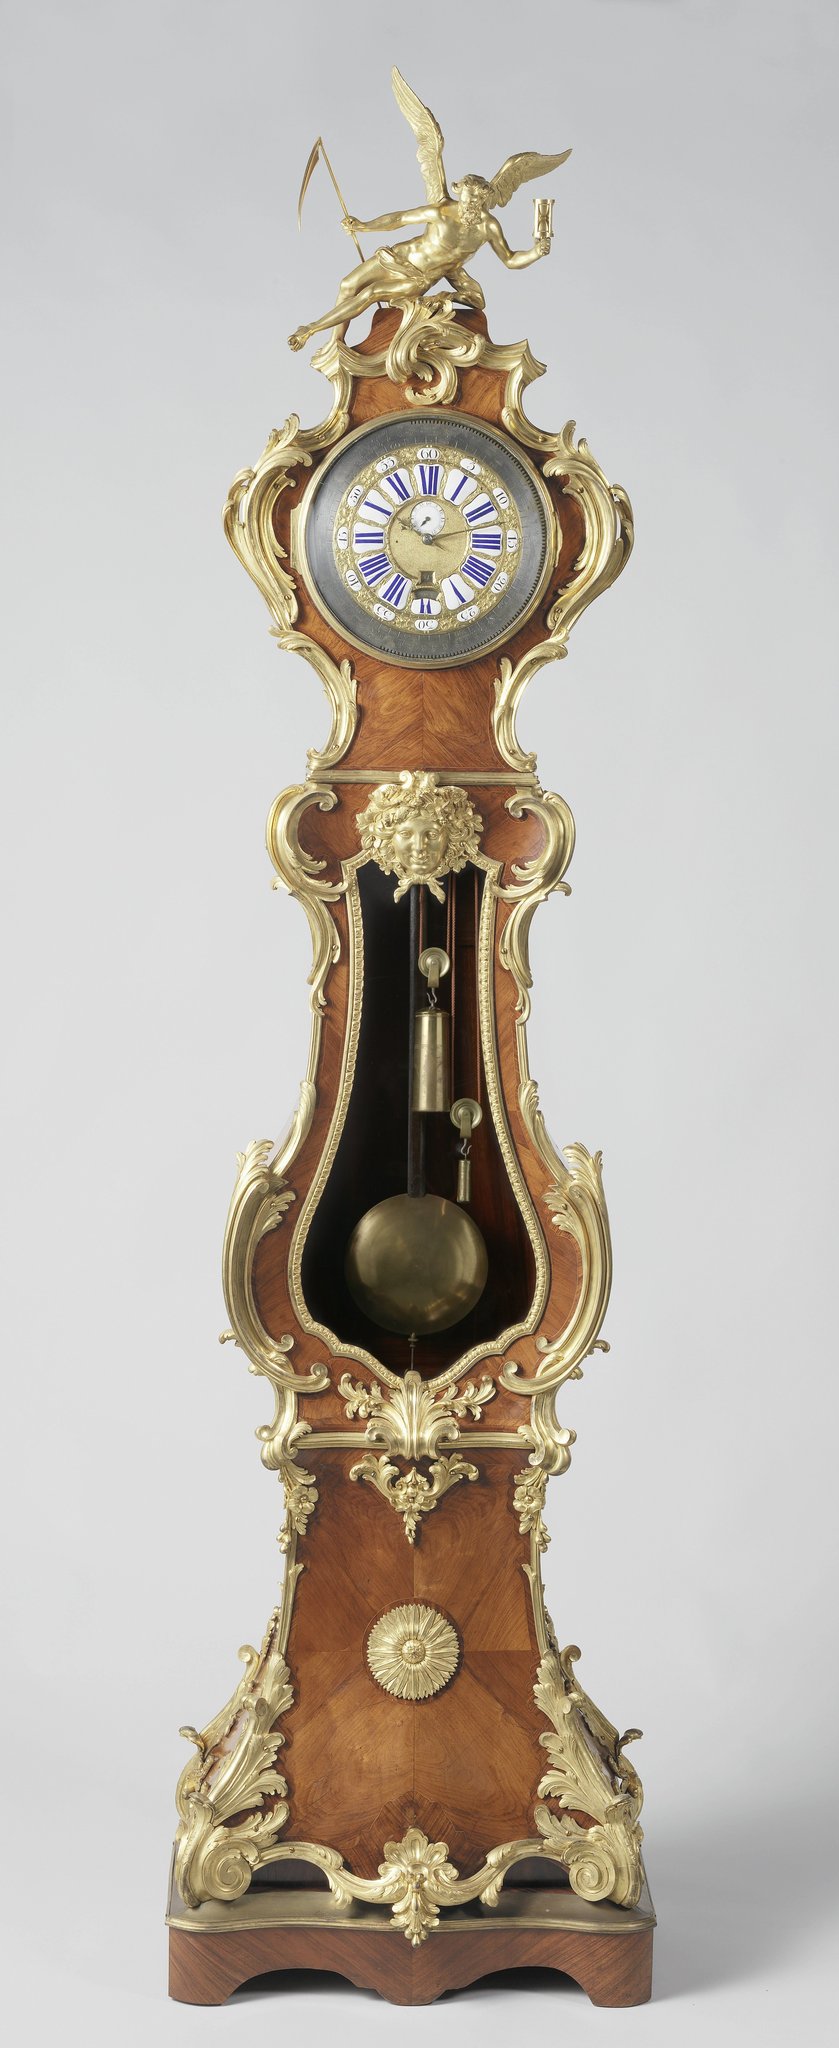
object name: clock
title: Longcase clock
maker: balthazar lieutaud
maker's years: -1780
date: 1760-1765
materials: bronze, glass, wood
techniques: gilding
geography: paris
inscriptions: inscription, mark, signature: ‘B.LIEUTAUD’, stamp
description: Because of its long pendulum, the movement of a longcase clock can be extremely precise. Longcase clocks were thus used to ‘regulate’ other clocks and timepieces. The French word for a longcase clock is régulateur (regulator). The gilt-bronze figure of a man with a scythe and an hourglass surmounting this clock represents Father Time.